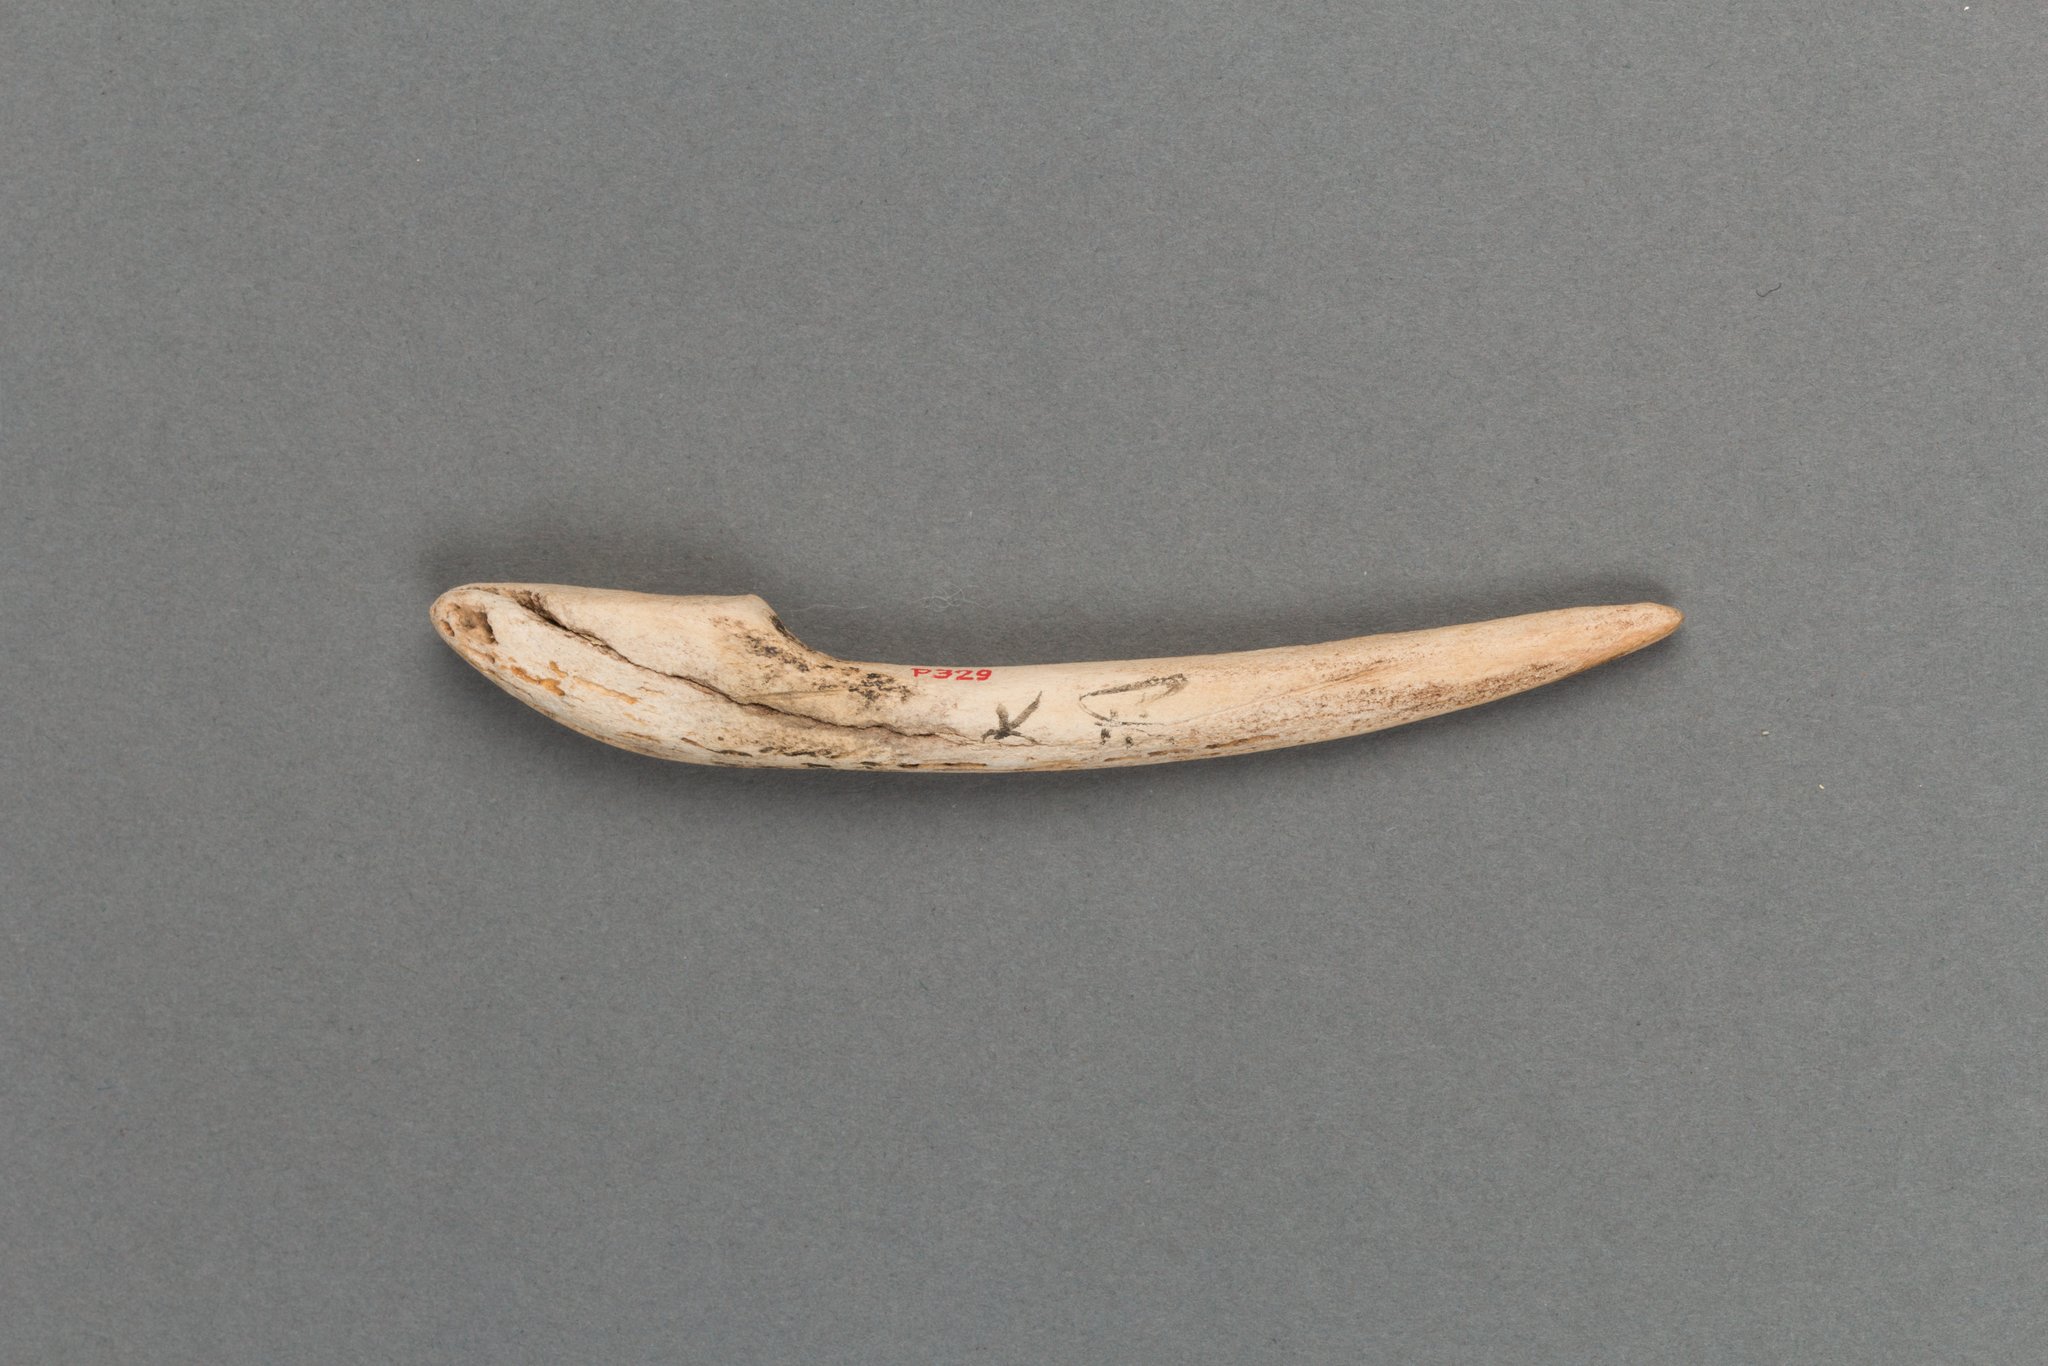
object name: harpoon head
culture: japanese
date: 1200-200 BCE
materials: bone